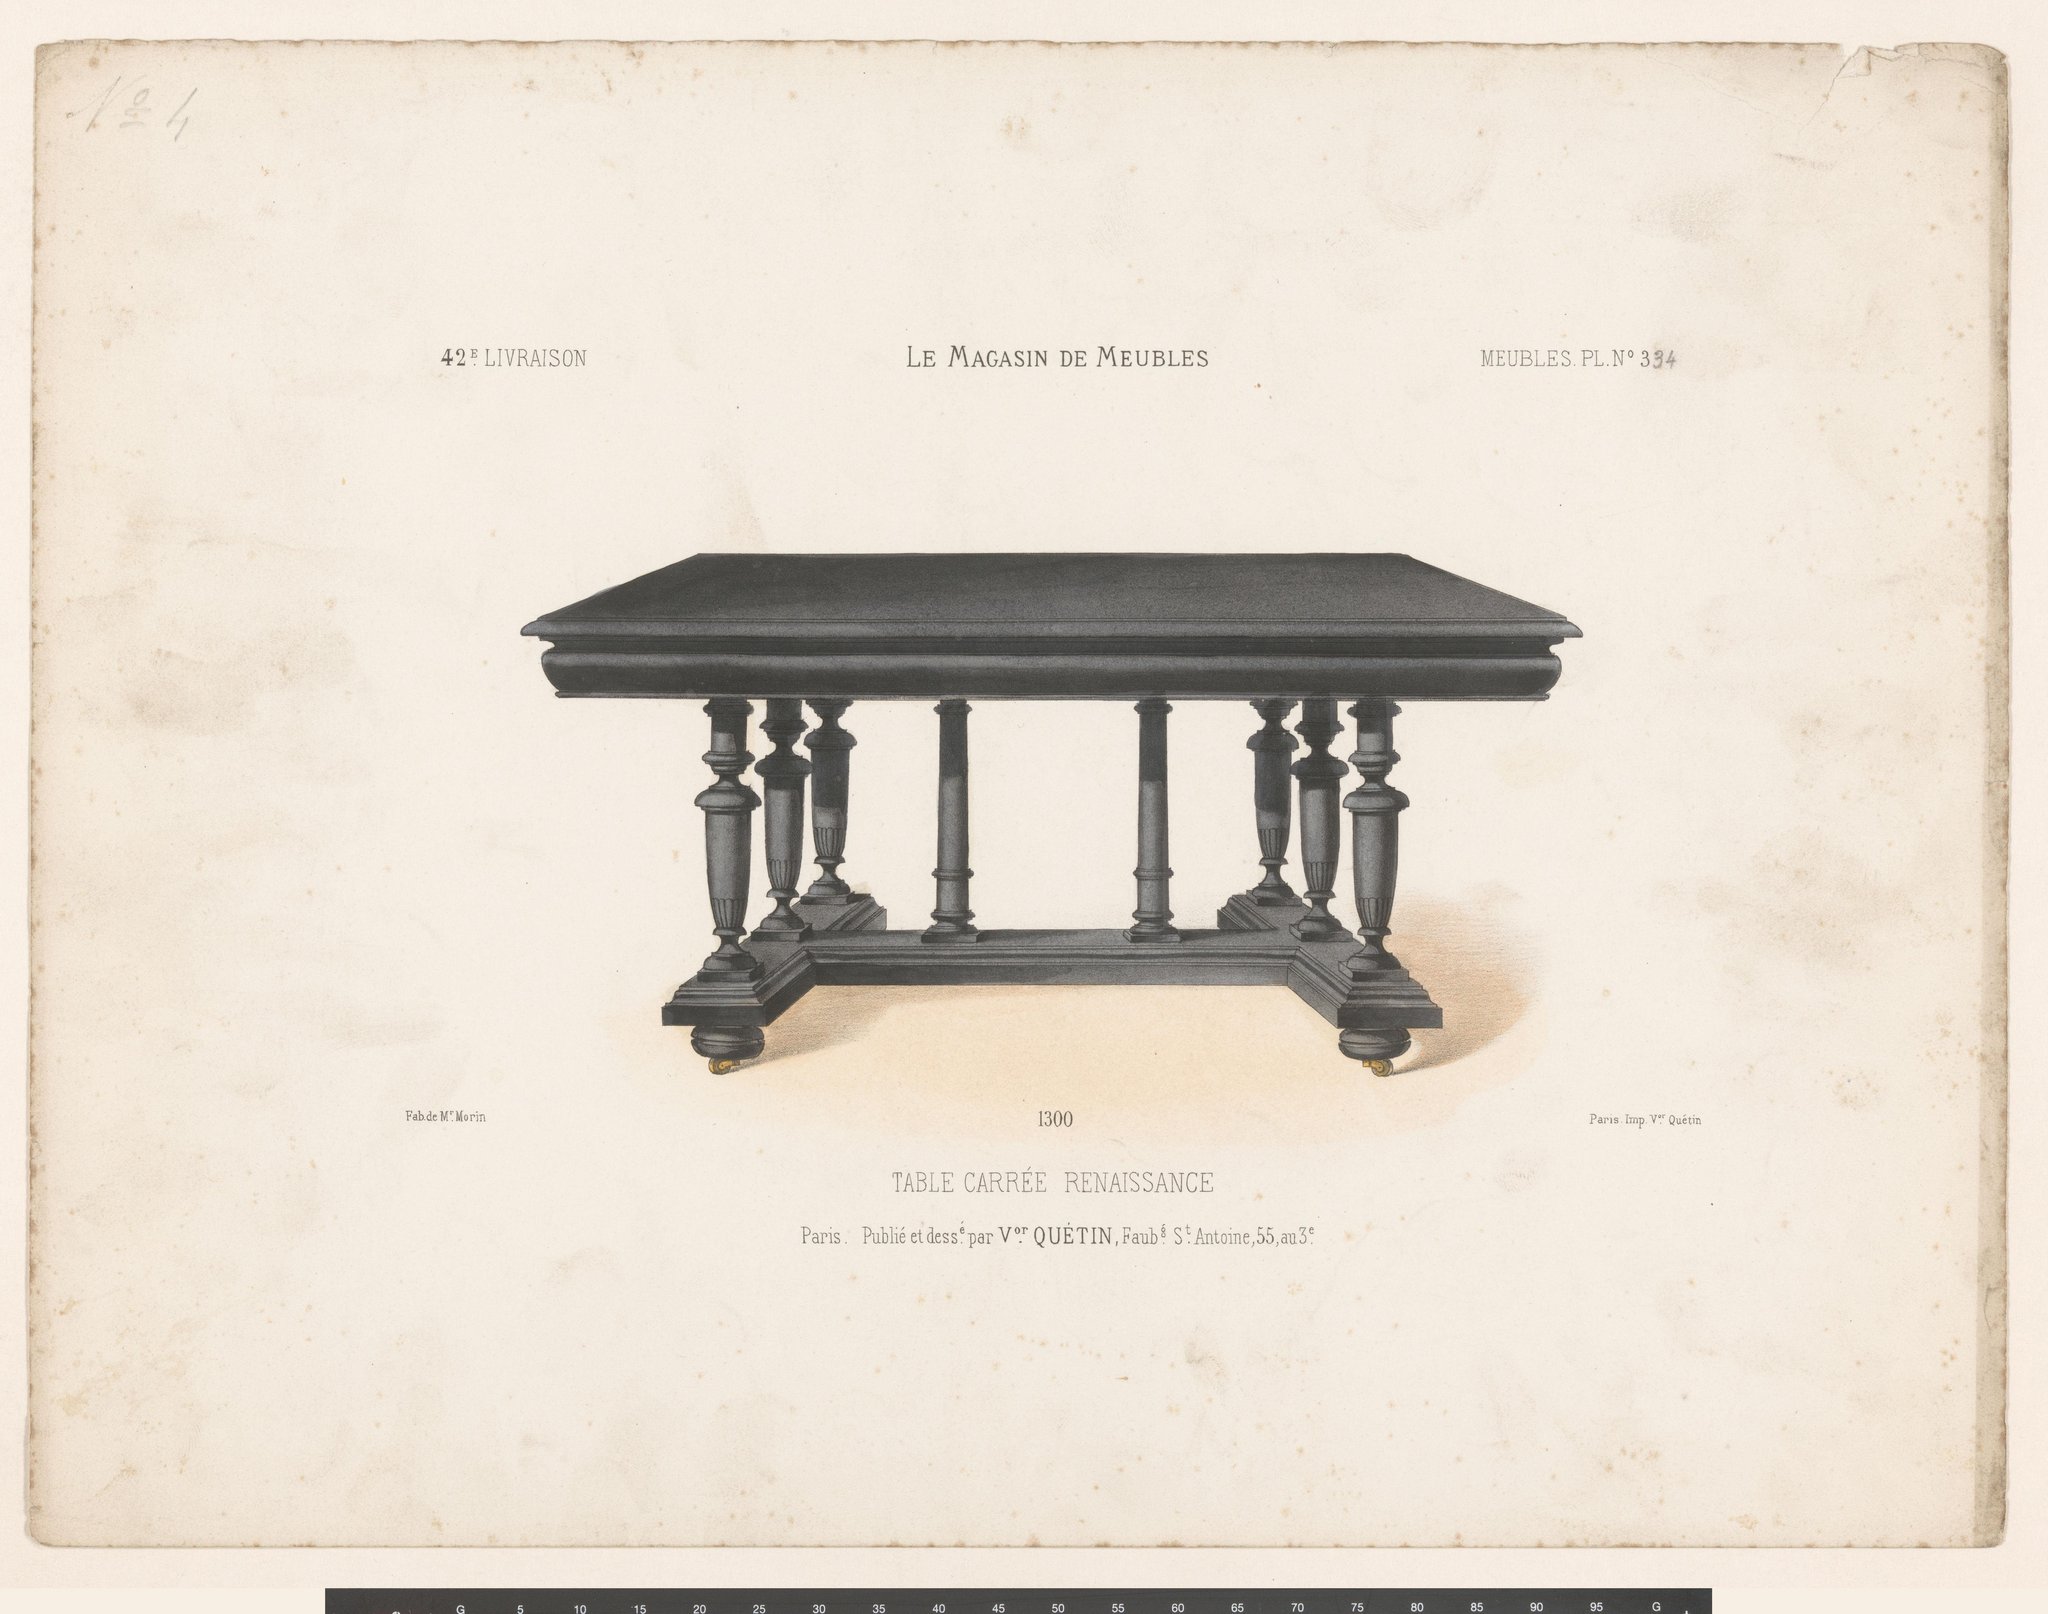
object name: print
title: Tafel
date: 1832-1877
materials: paper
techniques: hand coloring, lithograph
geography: paris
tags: table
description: Een rechthoekige renaissance tafel. Prent uit 42e Livraison.